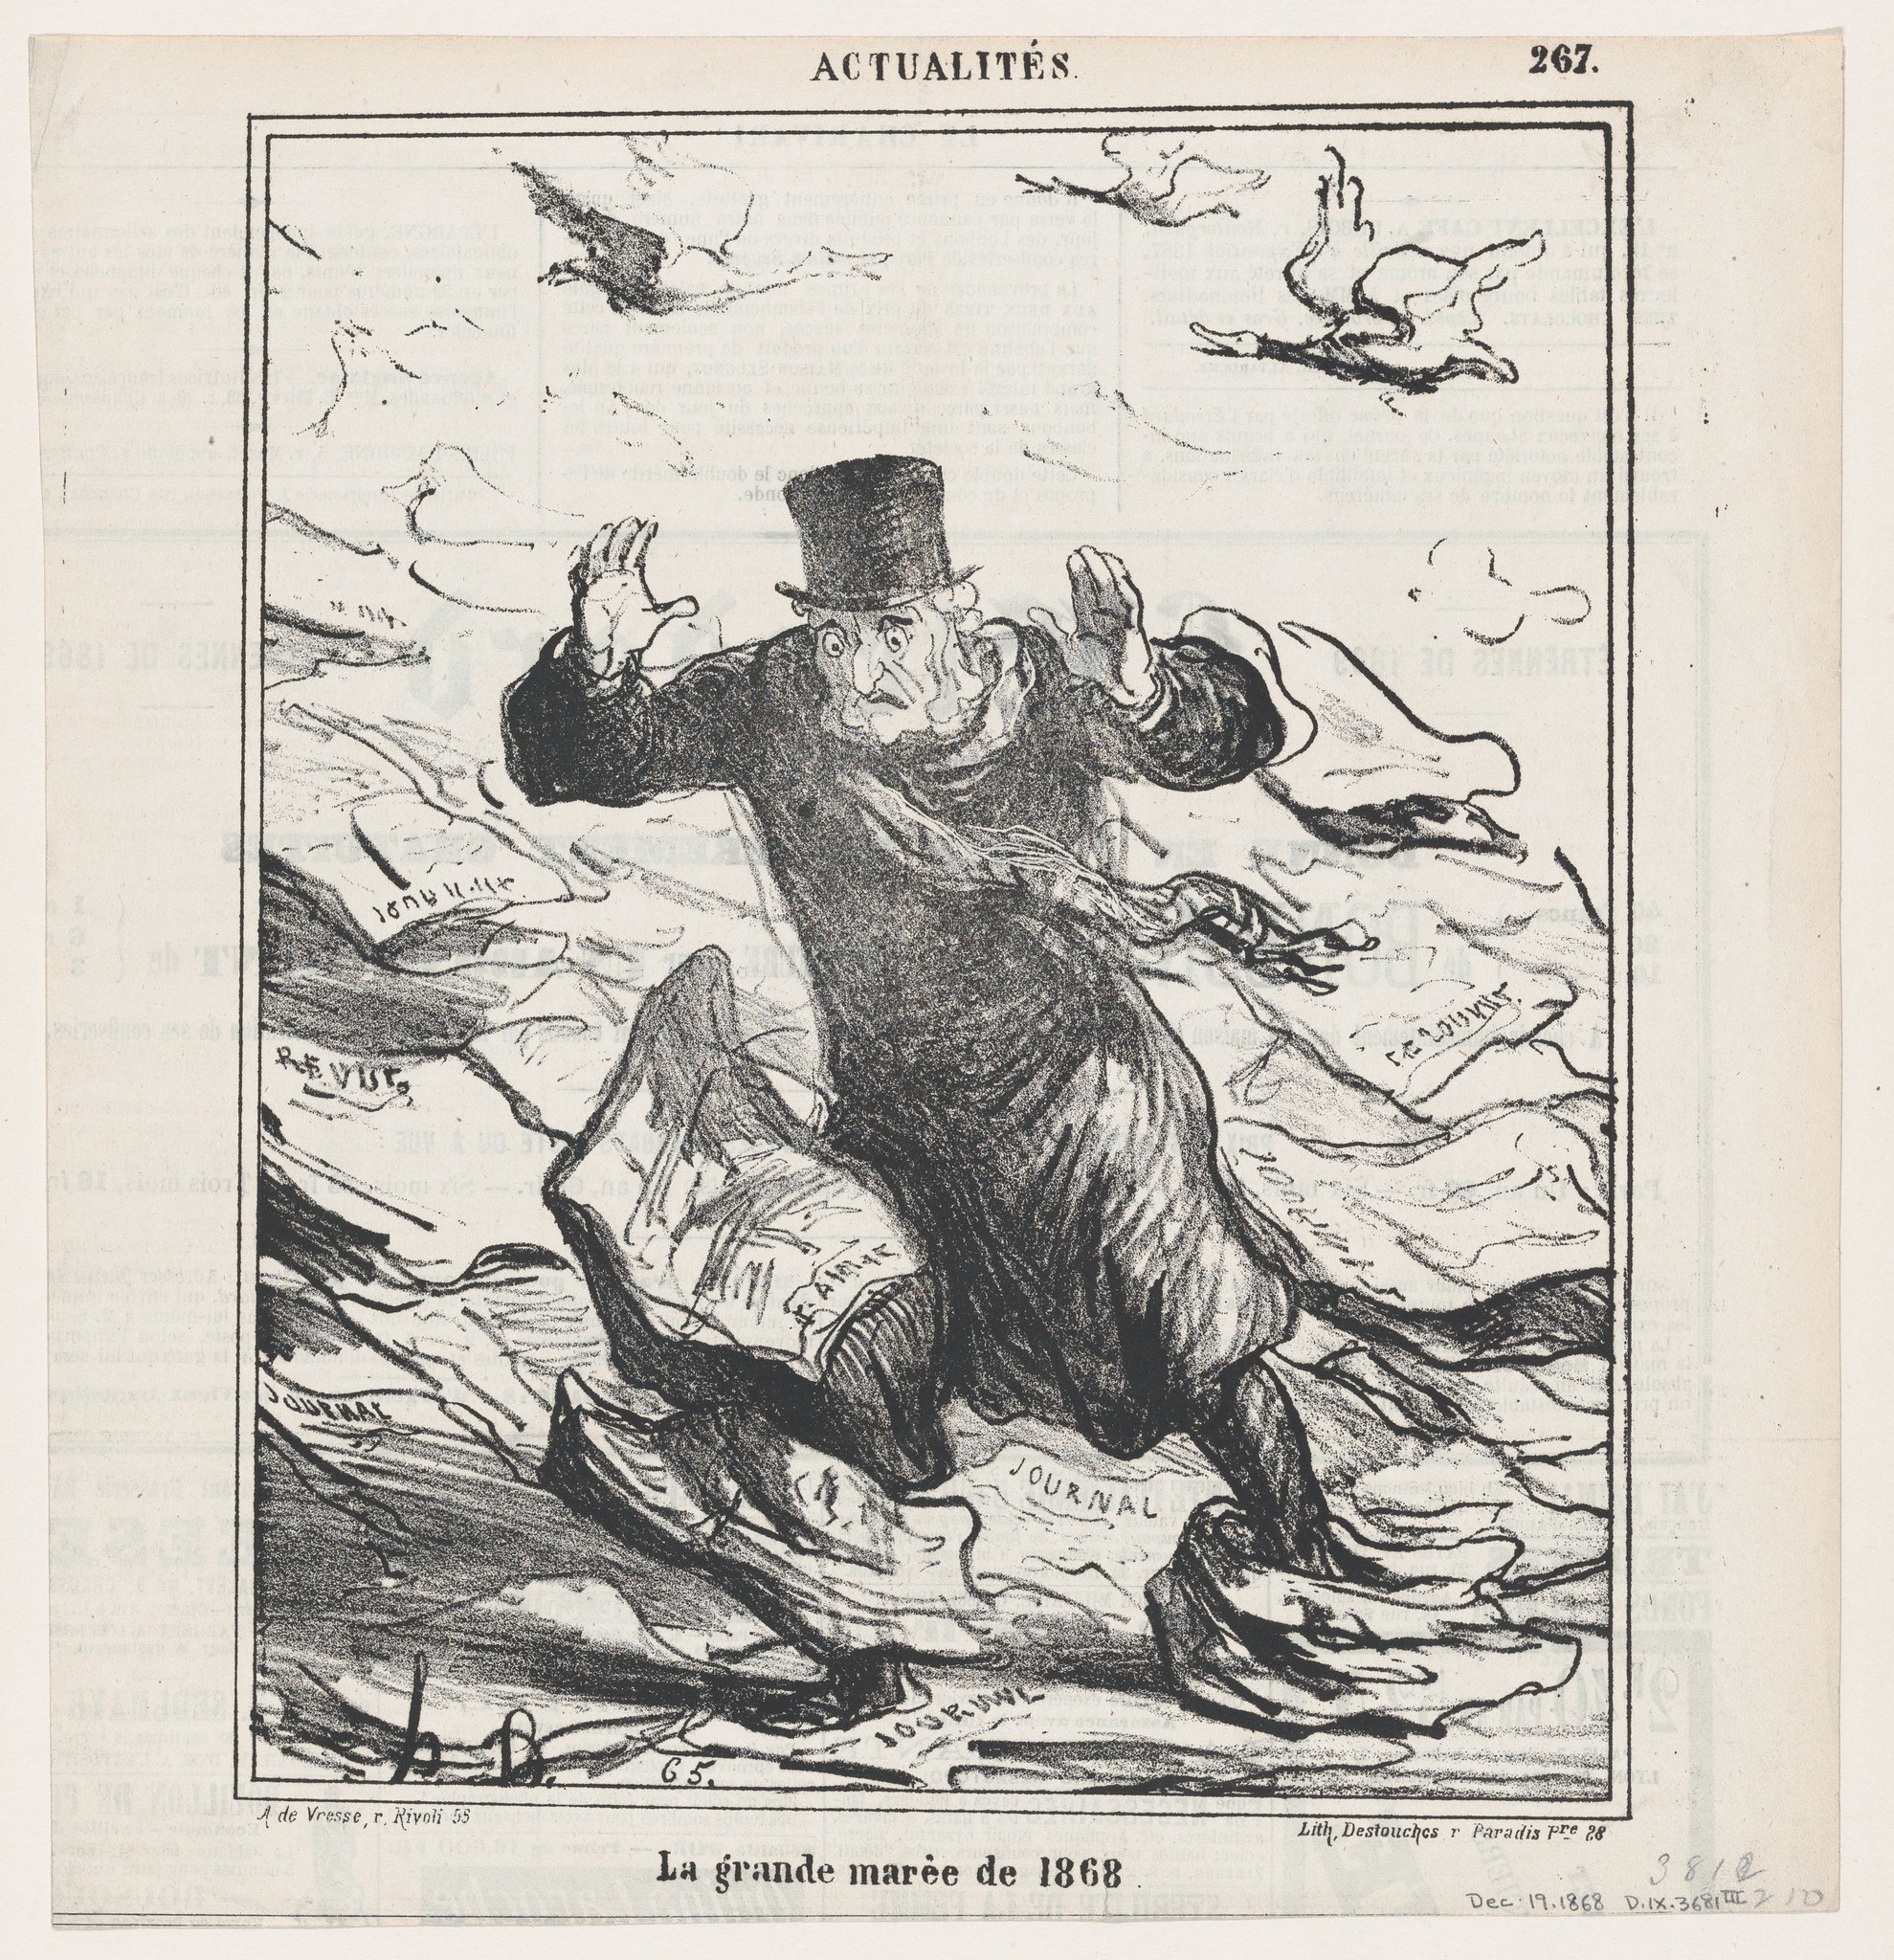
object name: print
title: The spring-tide of 1868, from "News of the day"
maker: honoré daumier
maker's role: artist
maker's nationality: french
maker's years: 1808-1879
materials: paper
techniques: lithograph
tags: birds,satire,men